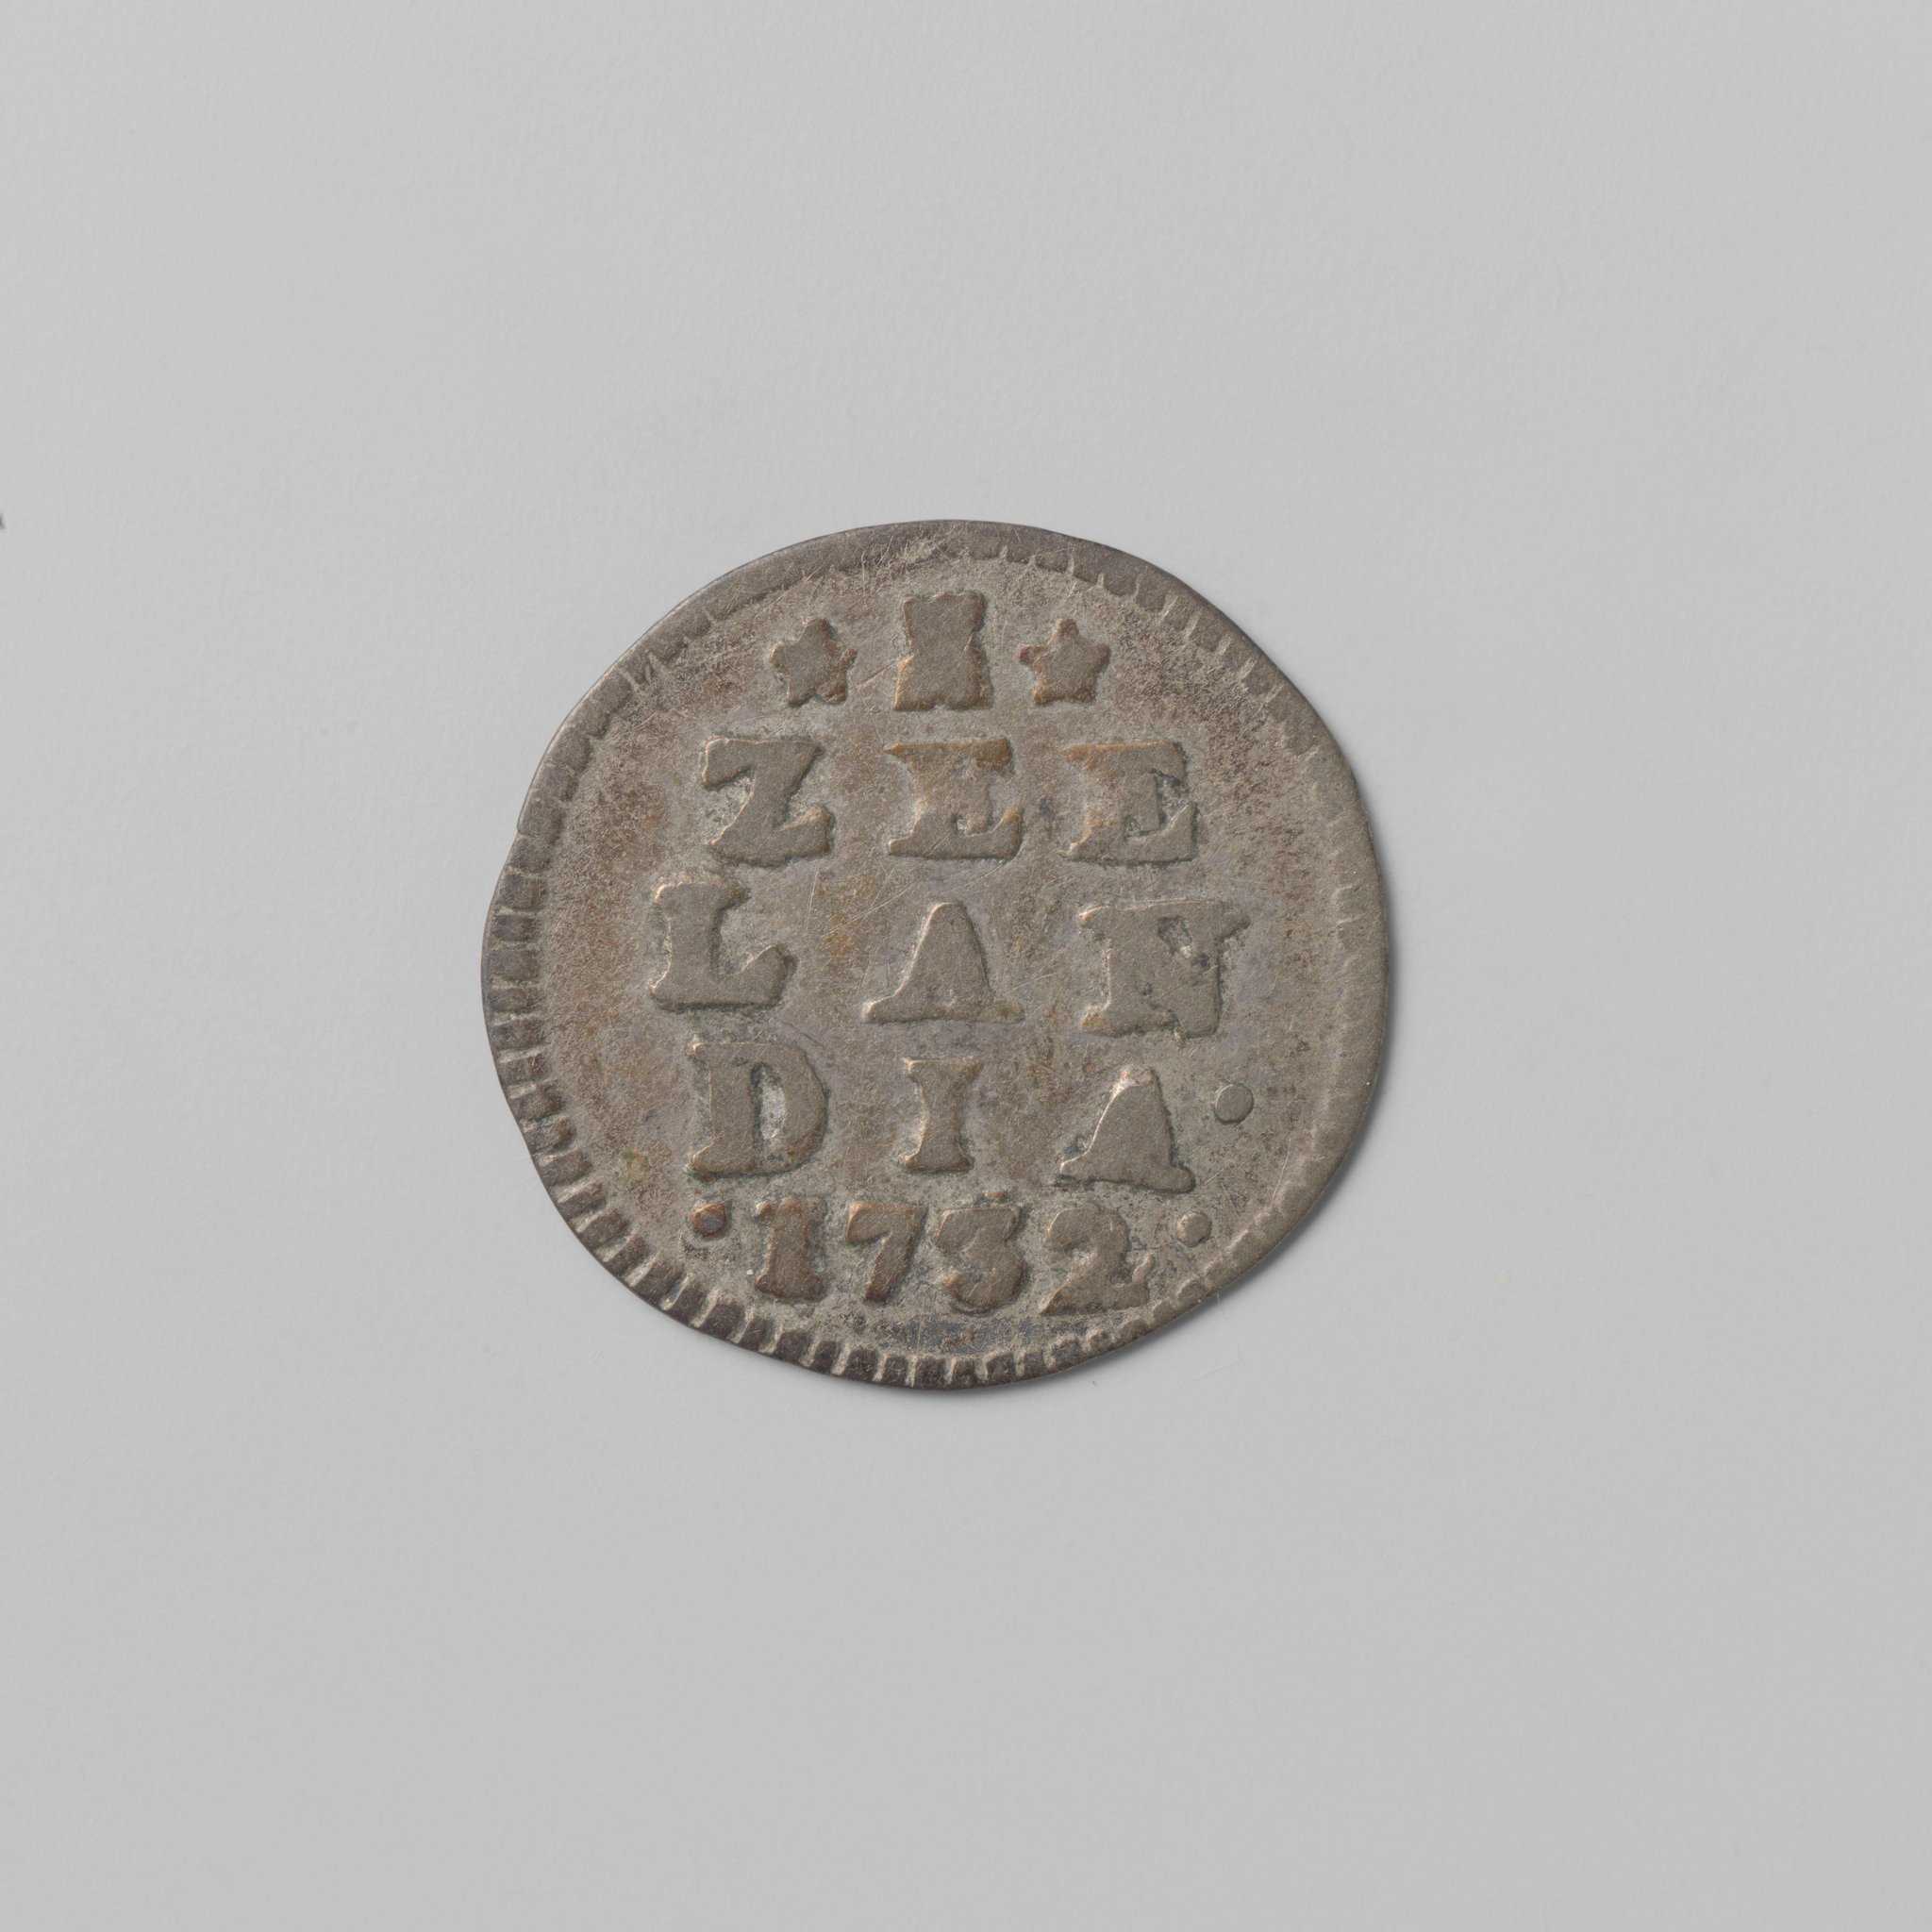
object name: coin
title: Zeeuwse dubbele stuiver, 1732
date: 1732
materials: silver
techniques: striking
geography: middelburg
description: Zilveren munt. Voorzijde: tussen waarde-aanduiding 2 S gekroond wapenschild van Zeeland. Keerzijde: opschrift in drie regels, waarboven muntteken burcht tussen twee rozetten en waaronder jaartal.